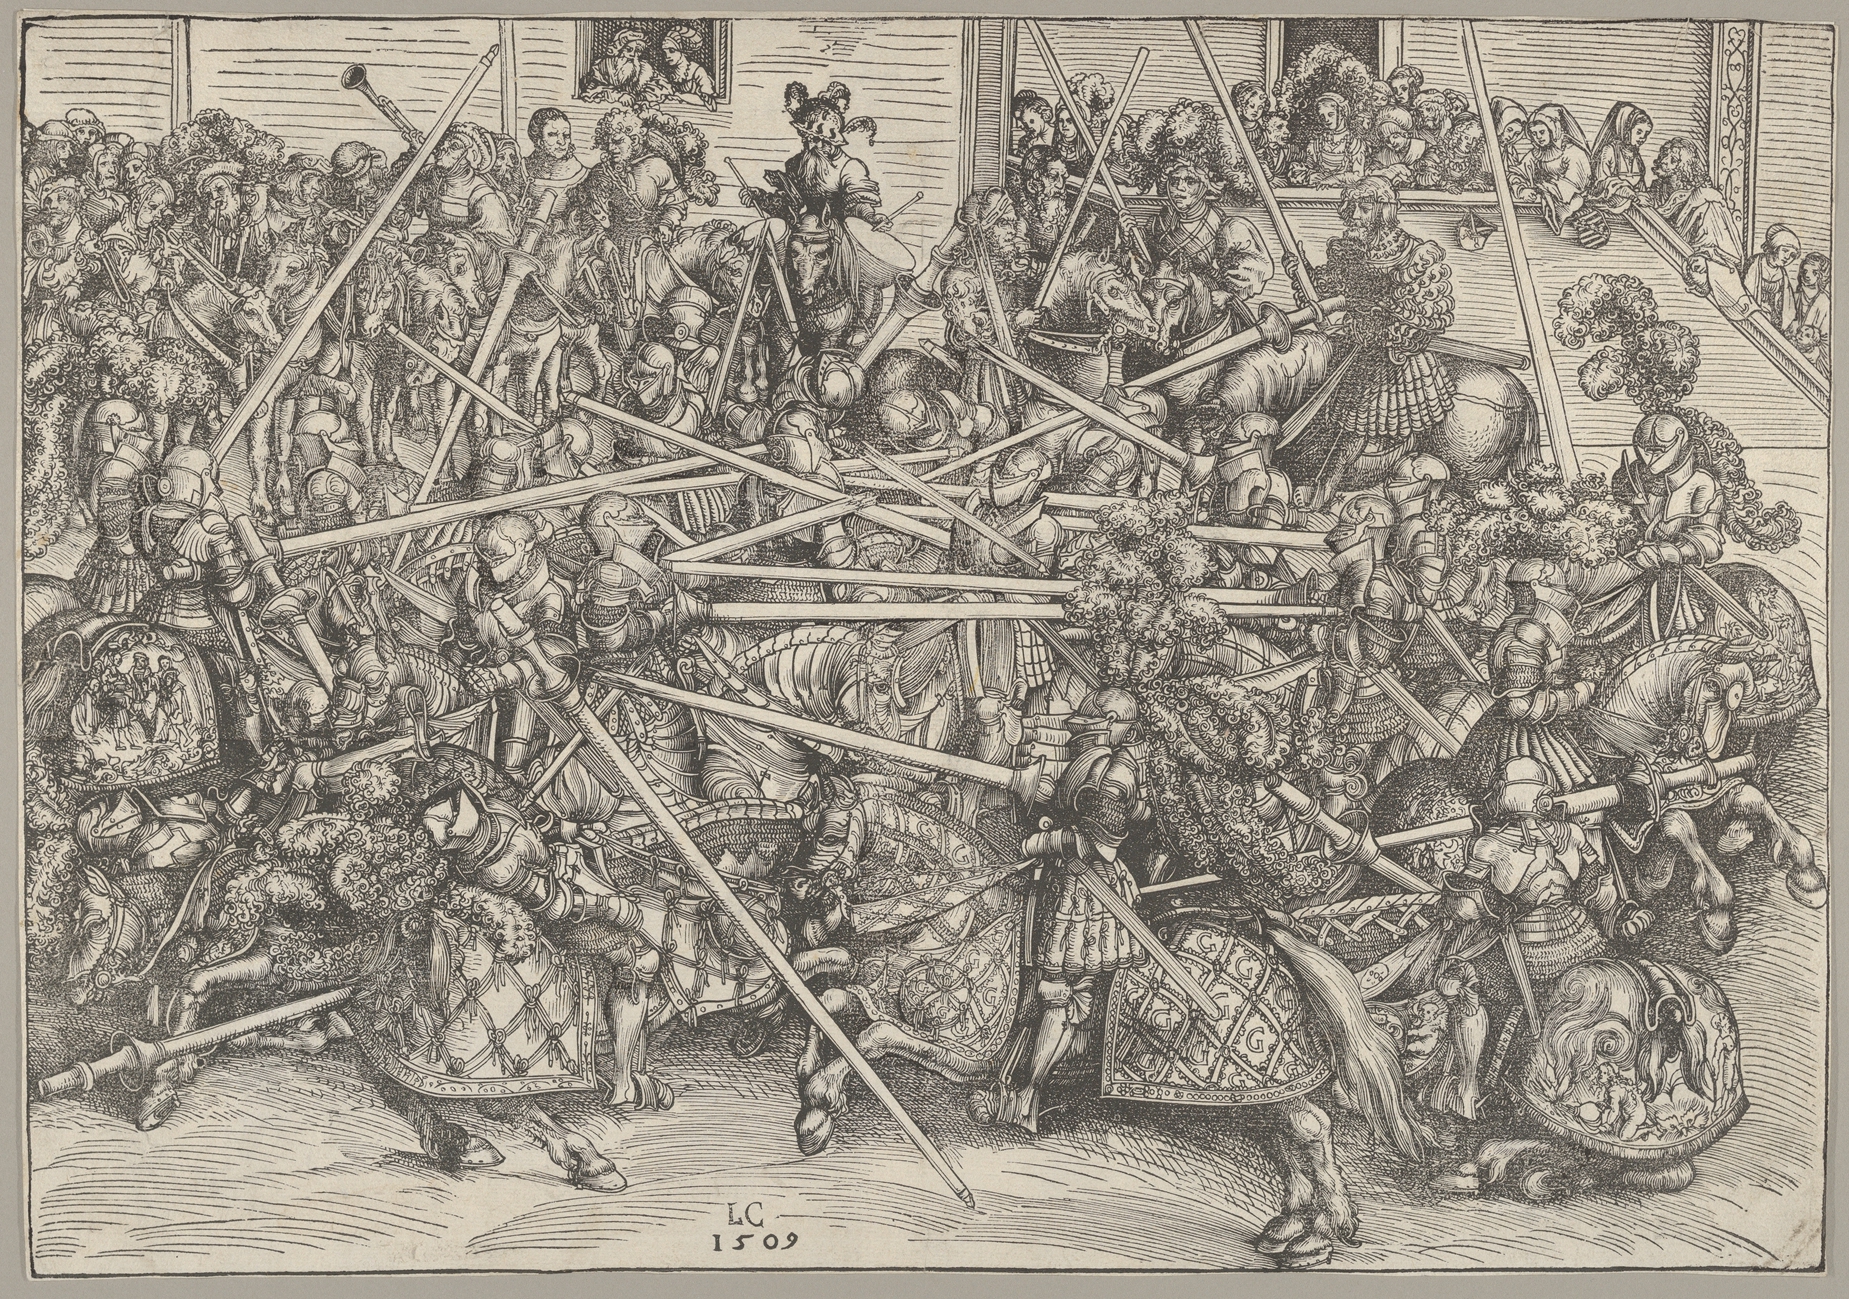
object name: print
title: The Third Tournament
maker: lucas cranach the elder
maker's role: artist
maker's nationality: german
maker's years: 1472-1553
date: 1509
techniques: woodcut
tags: soldiers,weapons,men,women,horses